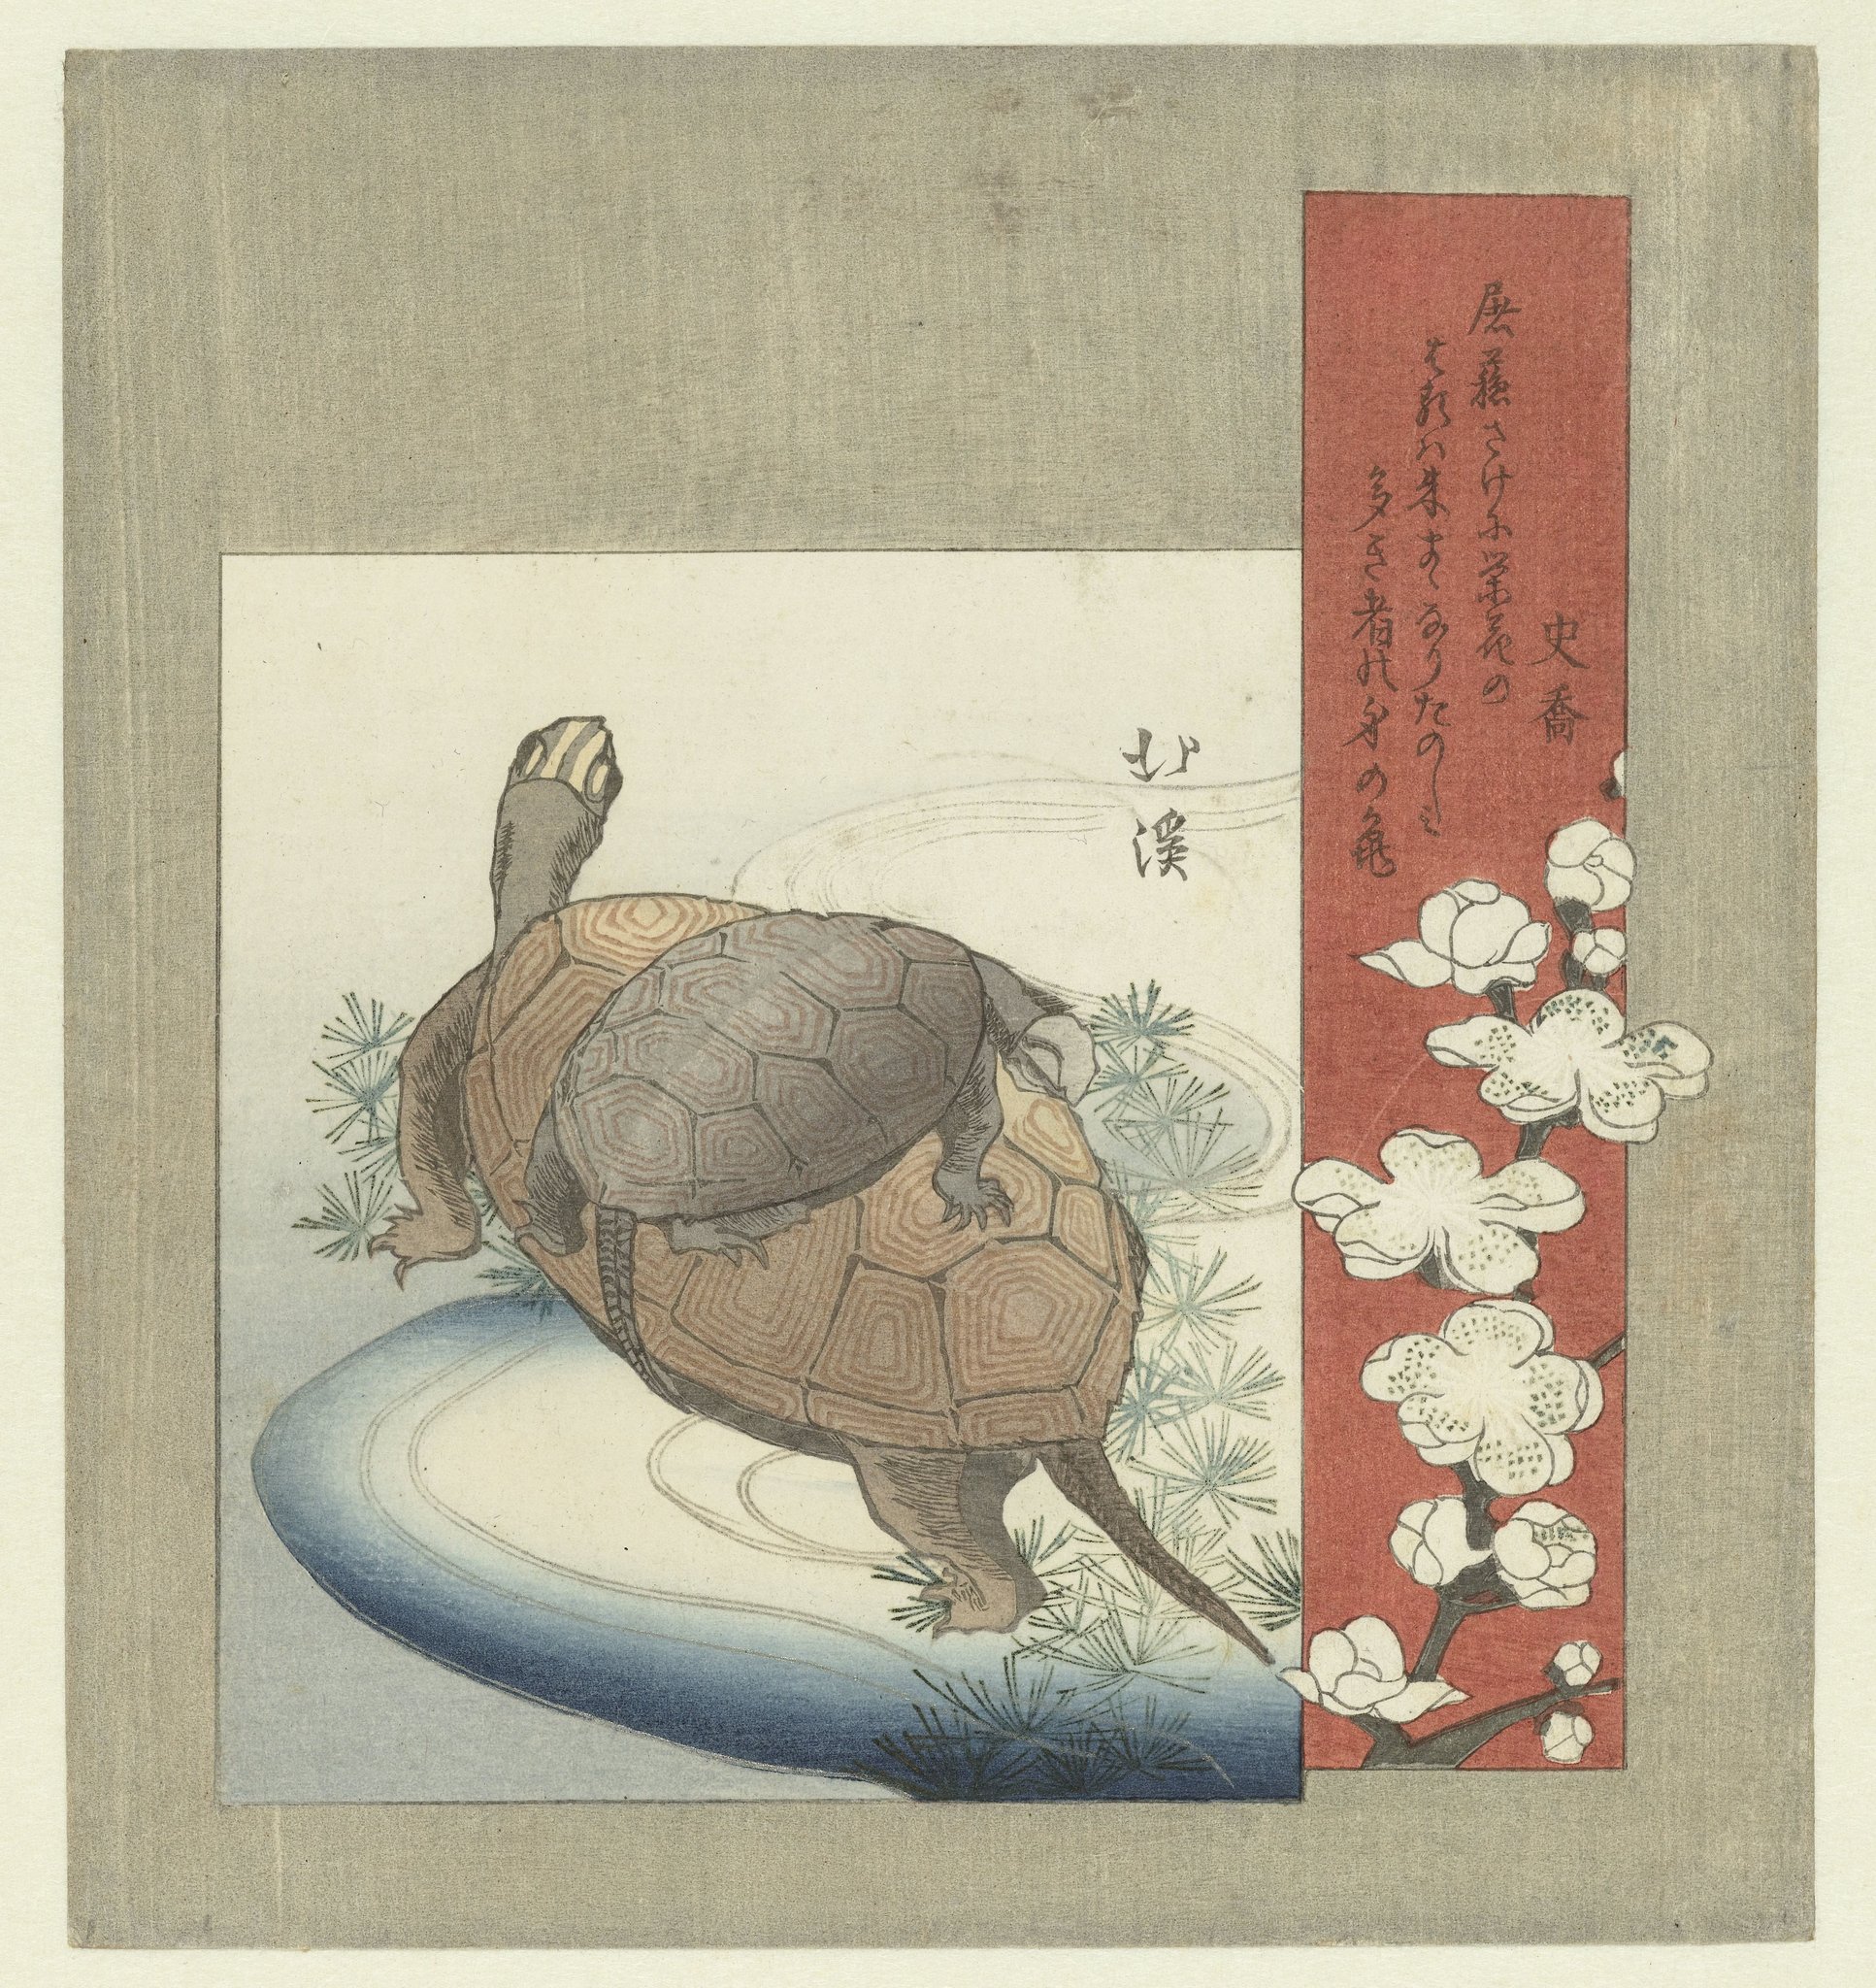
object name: surimono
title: Schildpadden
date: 1826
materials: paper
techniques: blind stamped, woodcut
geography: japan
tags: tortoises, turtles, plants; vegetation (+ flowers, blossom, blossoming)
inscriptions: collector's mark, passe-partout, bottom left, printed: JABdH with a rooster., collector's mark, verso, stamped: Lugt 2228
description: Een surimono is een luxe uitgevoerde prent waarop beeld met één of meerdere gedichten gecombineerd is. Bij het drukken van een surimono werd vaak gebruik gemaakt van dikker papier, blinddruk en metaal pigmenten, zoals koper- en zilverpoeder. De prenten werden vaak in opdracht van dichters gemaakt en als exclusief geschenk aan vrienden en relaties gegeven.